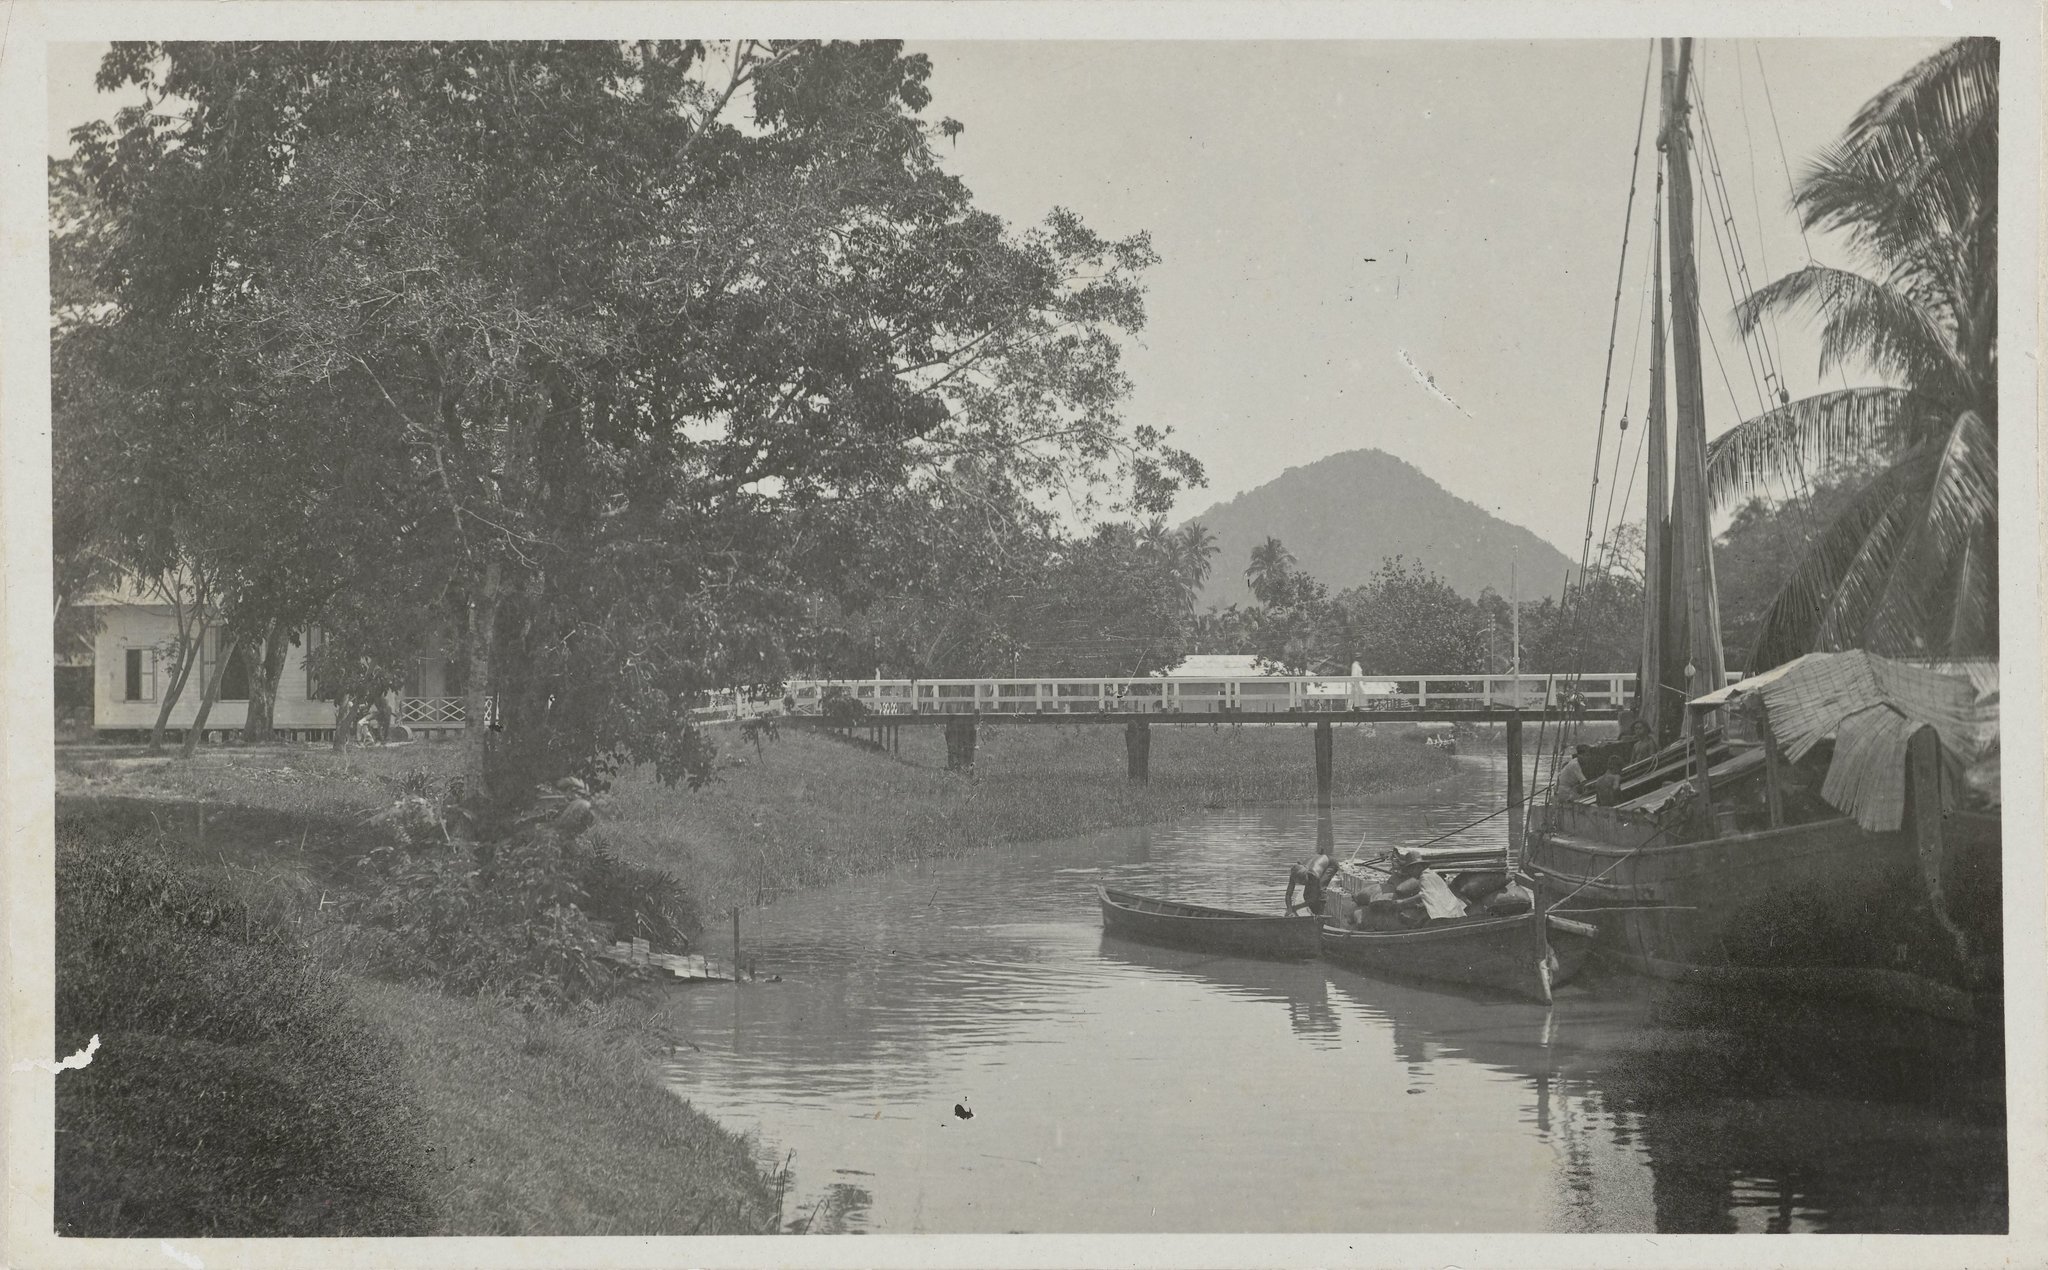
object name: photograph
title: Riviergezicht met brug in Singkawang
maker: Anonymous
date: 1920-1940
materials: photographic support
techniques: gelatin silver print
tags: borneo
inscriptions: annotation: ‘Post card, correspondence address only’